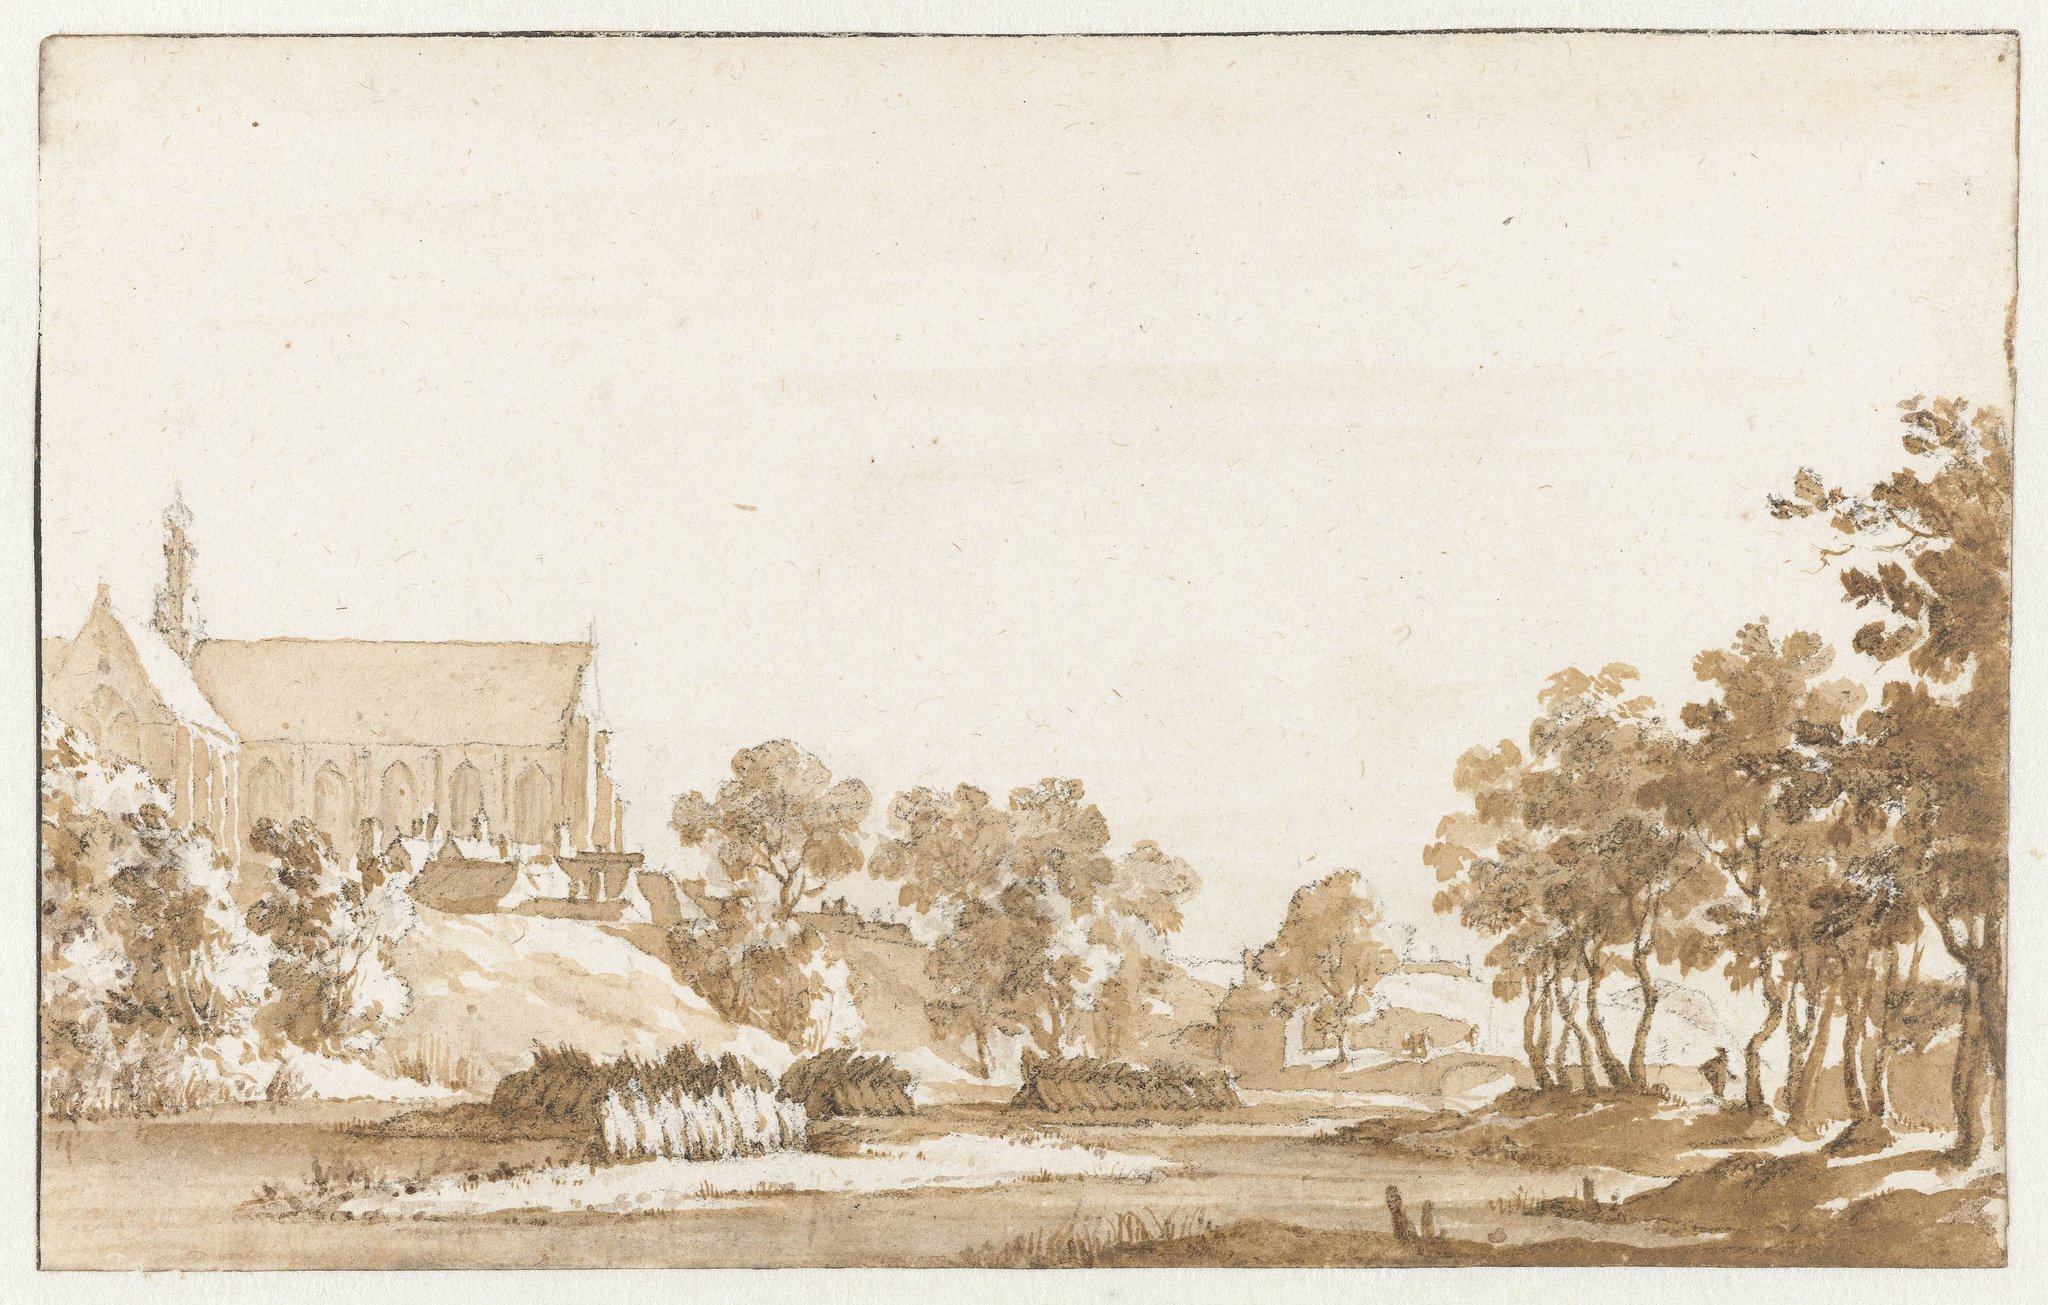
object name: drawing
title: Gezicht op de St. Laurenskerk te Alkmaar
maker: jan de bisschop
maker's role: draughtsman, print maker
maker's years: 1628-1671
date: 1648-1671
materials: chalk, paper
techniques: brush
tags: church (exterior)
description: Gezicht op de Grote of St. Laurenskerk te Alkmaar, vanuit het Noorden, over de wallen.